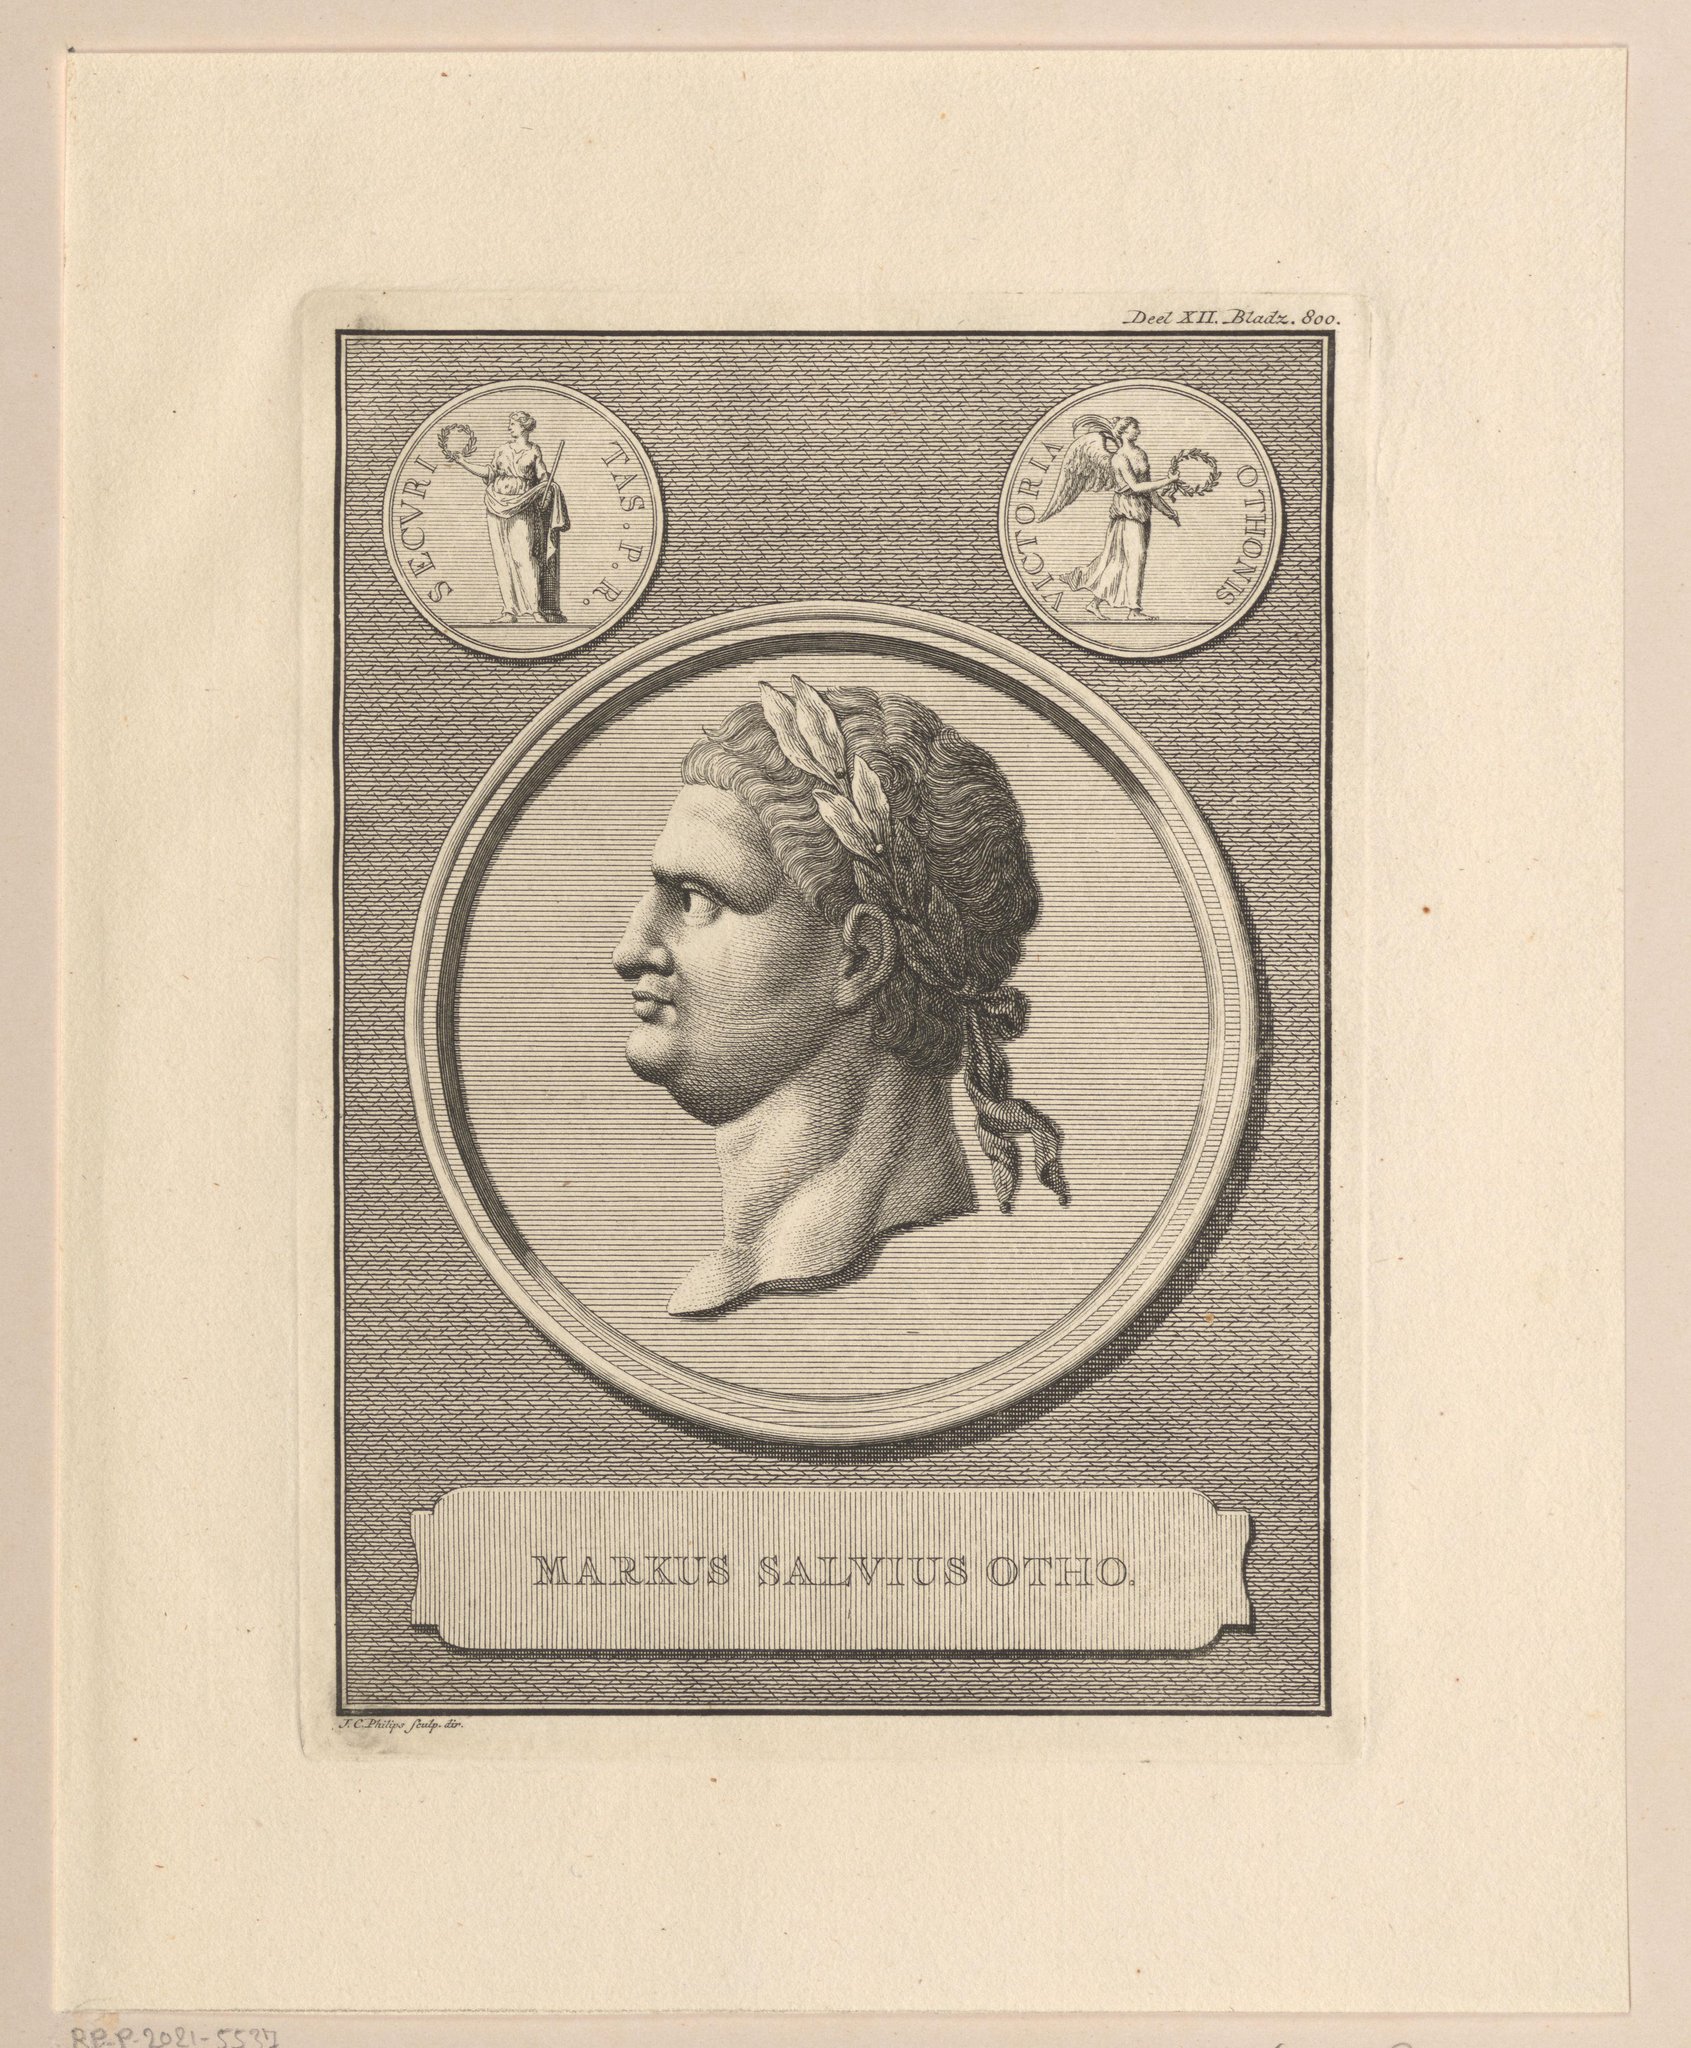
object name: print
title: Portret van Otho, keizer van het Romeinse Rijk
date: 1746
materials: paper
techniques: engraving, etching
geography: utrecht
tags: historical persons, coin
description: Prent waarschijnlijk uit: Westerbaen, Kornelis. Algemeene histori van het begin der wereld af tot den tegenwoordigen tijd toe. Utrecht: Hermanus Besseling, 1746, dl. 12.